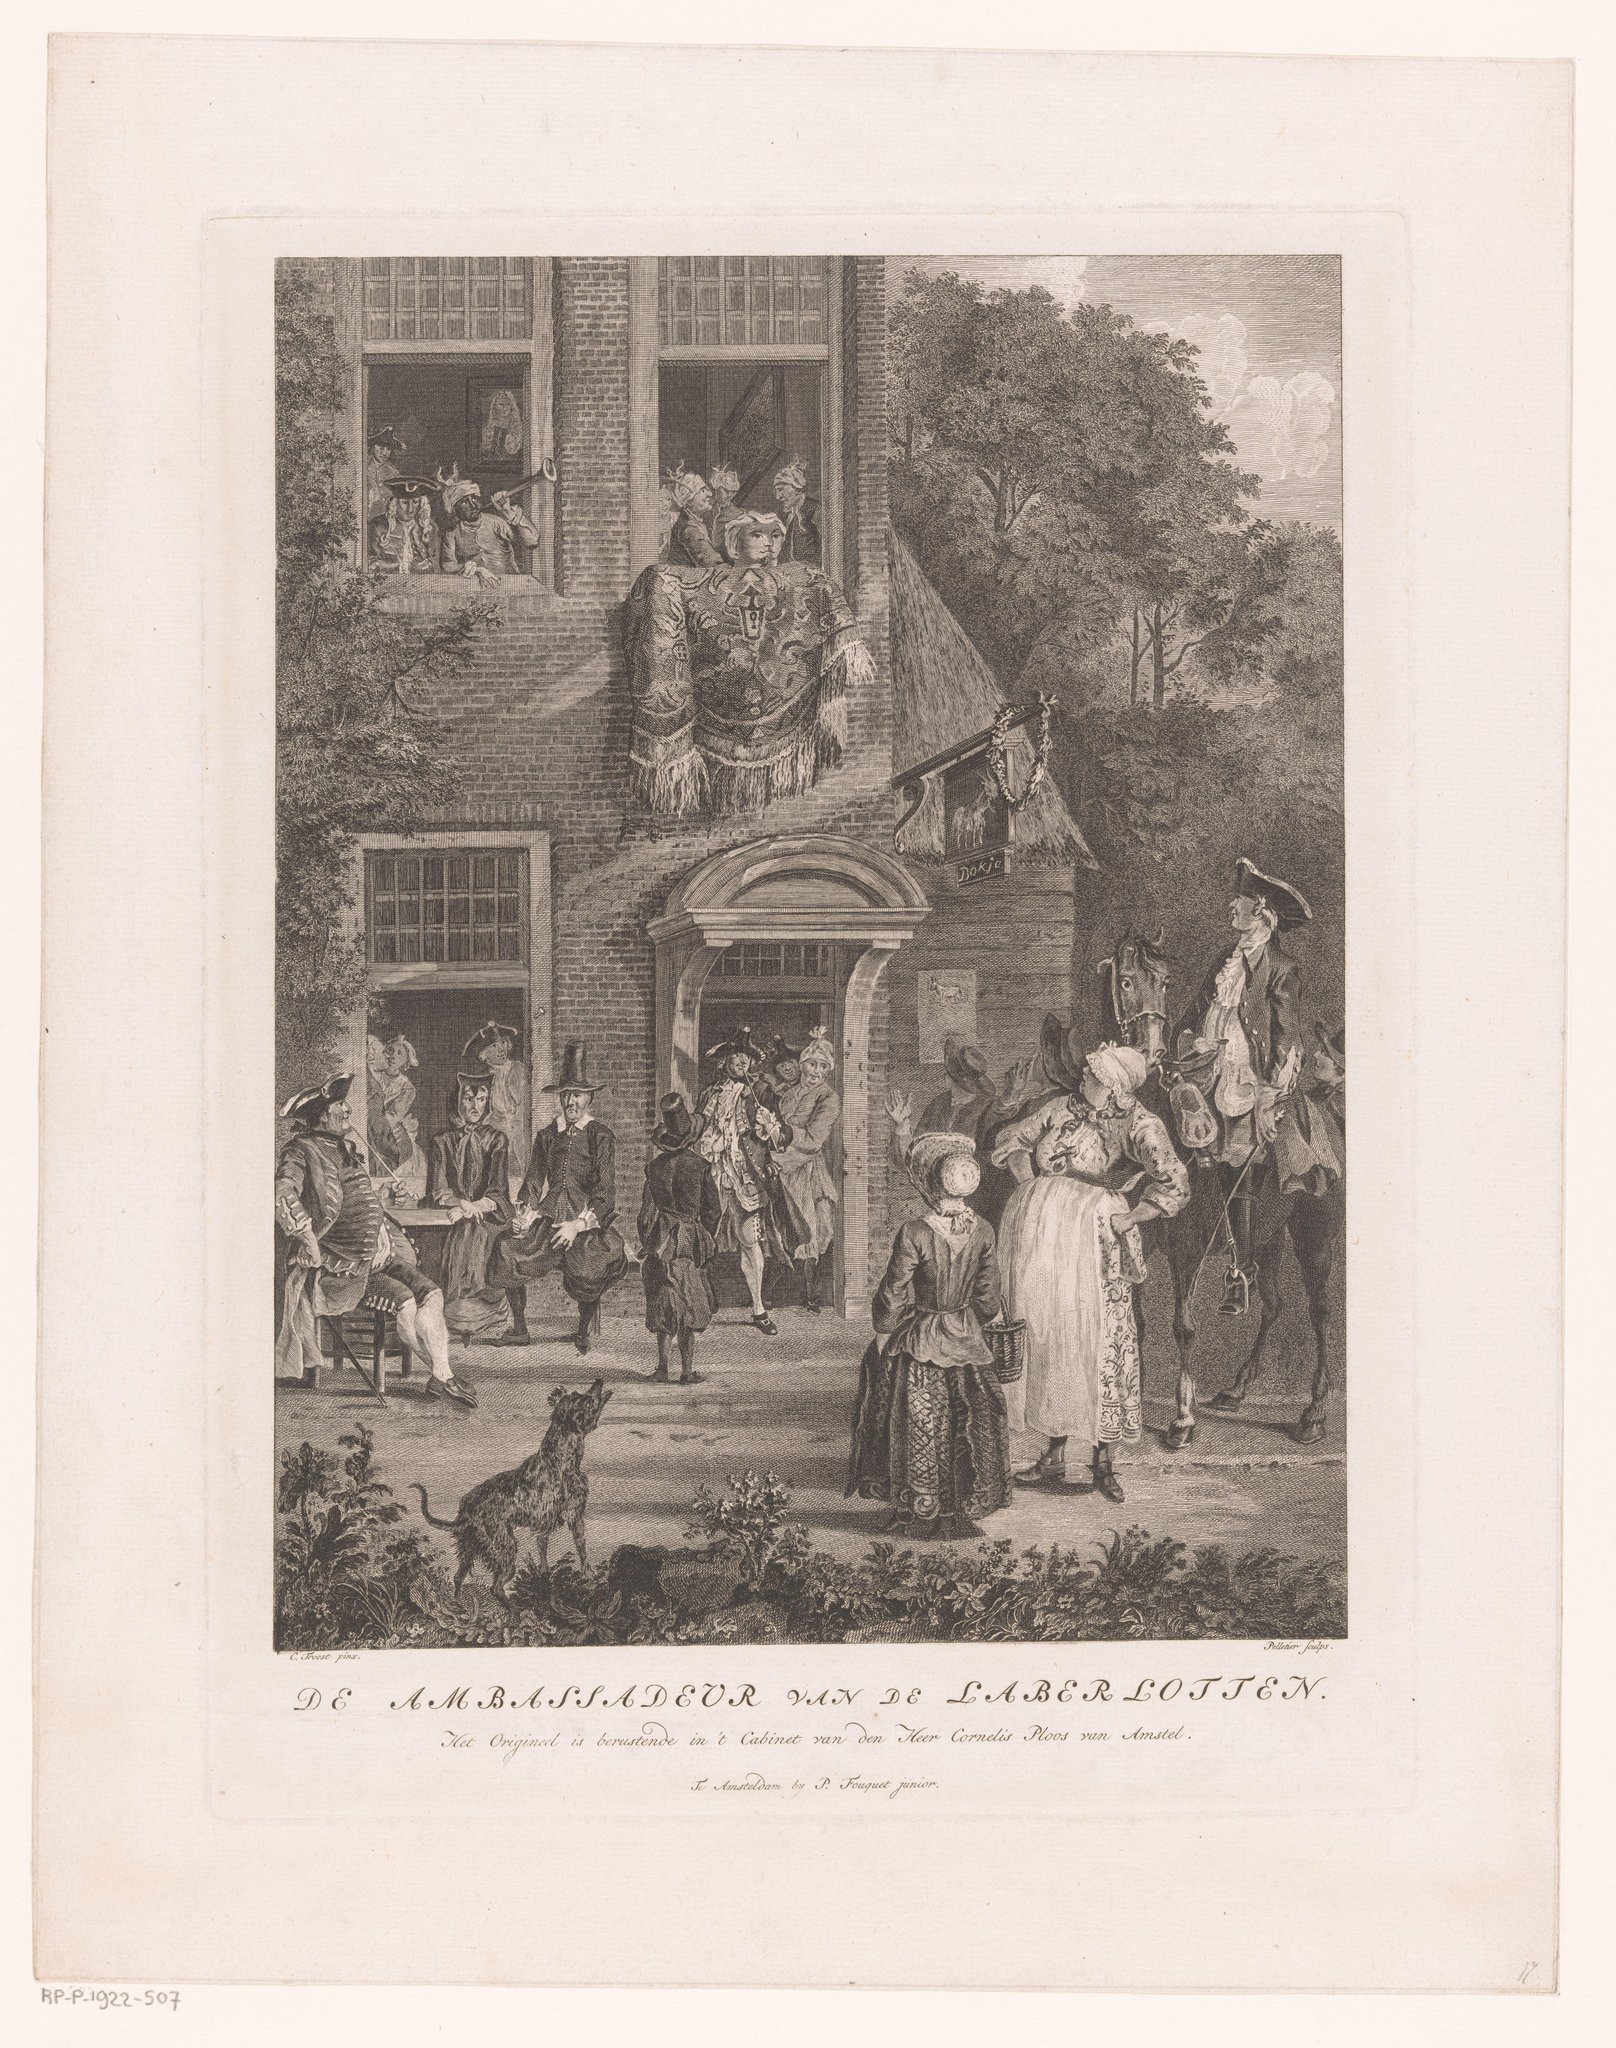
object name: print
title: De ambassadeur van de Laberlotten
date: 1757-1764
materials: paper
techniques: engraving, etching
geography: amsterdam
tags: amsterdam, painter, print maker, draughtsman, cornelis troost, protestant churches and denominations, buttocks, 'partes posteriores' - aa - female human figure, hotel, hostelry, inn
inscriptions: collector's mark: Lugt 2233, collector's mark: Lugt 2228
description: Een protestants koppel zit voor een herberg met voor een raam iemand met een gezicht op het achterwerk geschilderd. Dit was een grap van de waardin om meer bezoekers te trekken. Links bij het koppel aan tafel zit de schilder, Cornelis Troost, zelf.